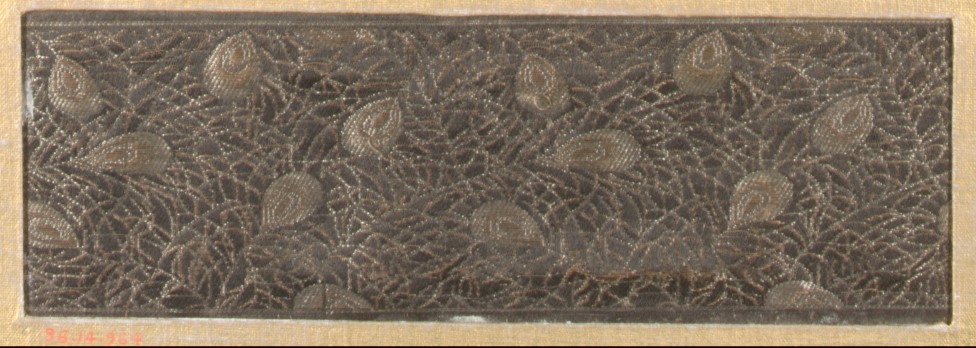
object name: piece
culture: japanese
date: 1701-1900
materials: silk